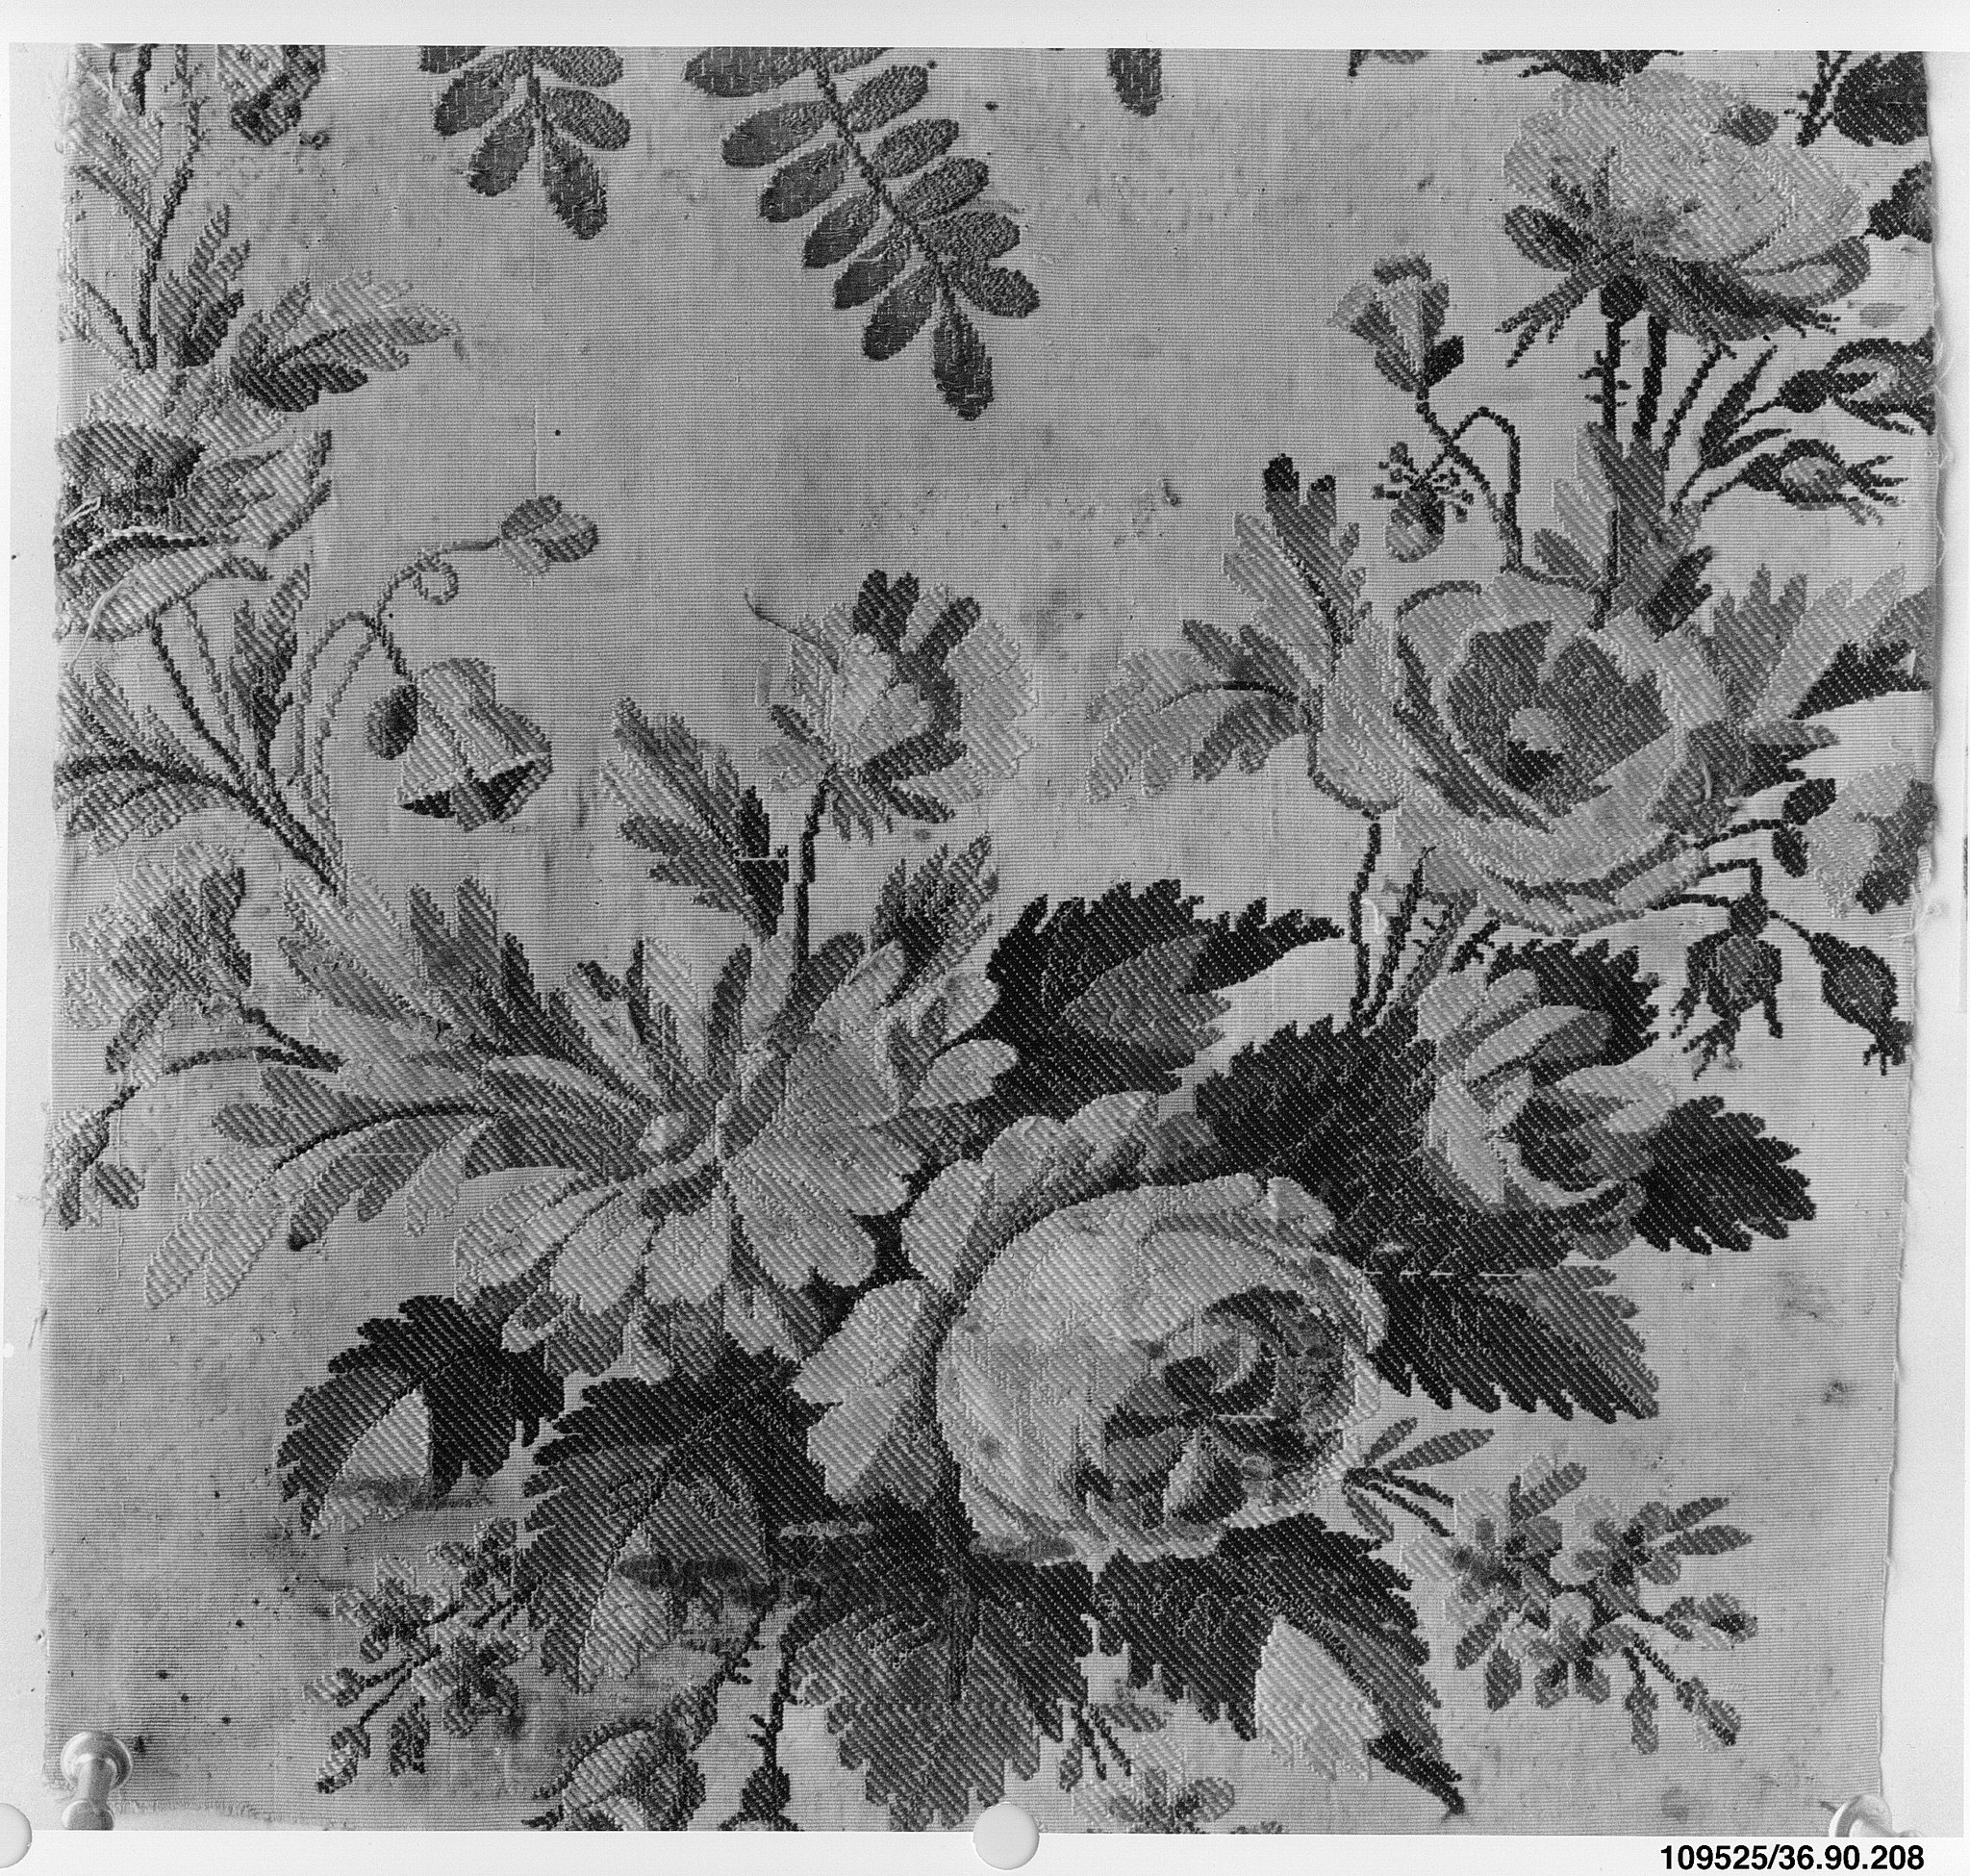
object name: piece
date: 1750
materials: metal thread, silk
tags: flowers,leaves